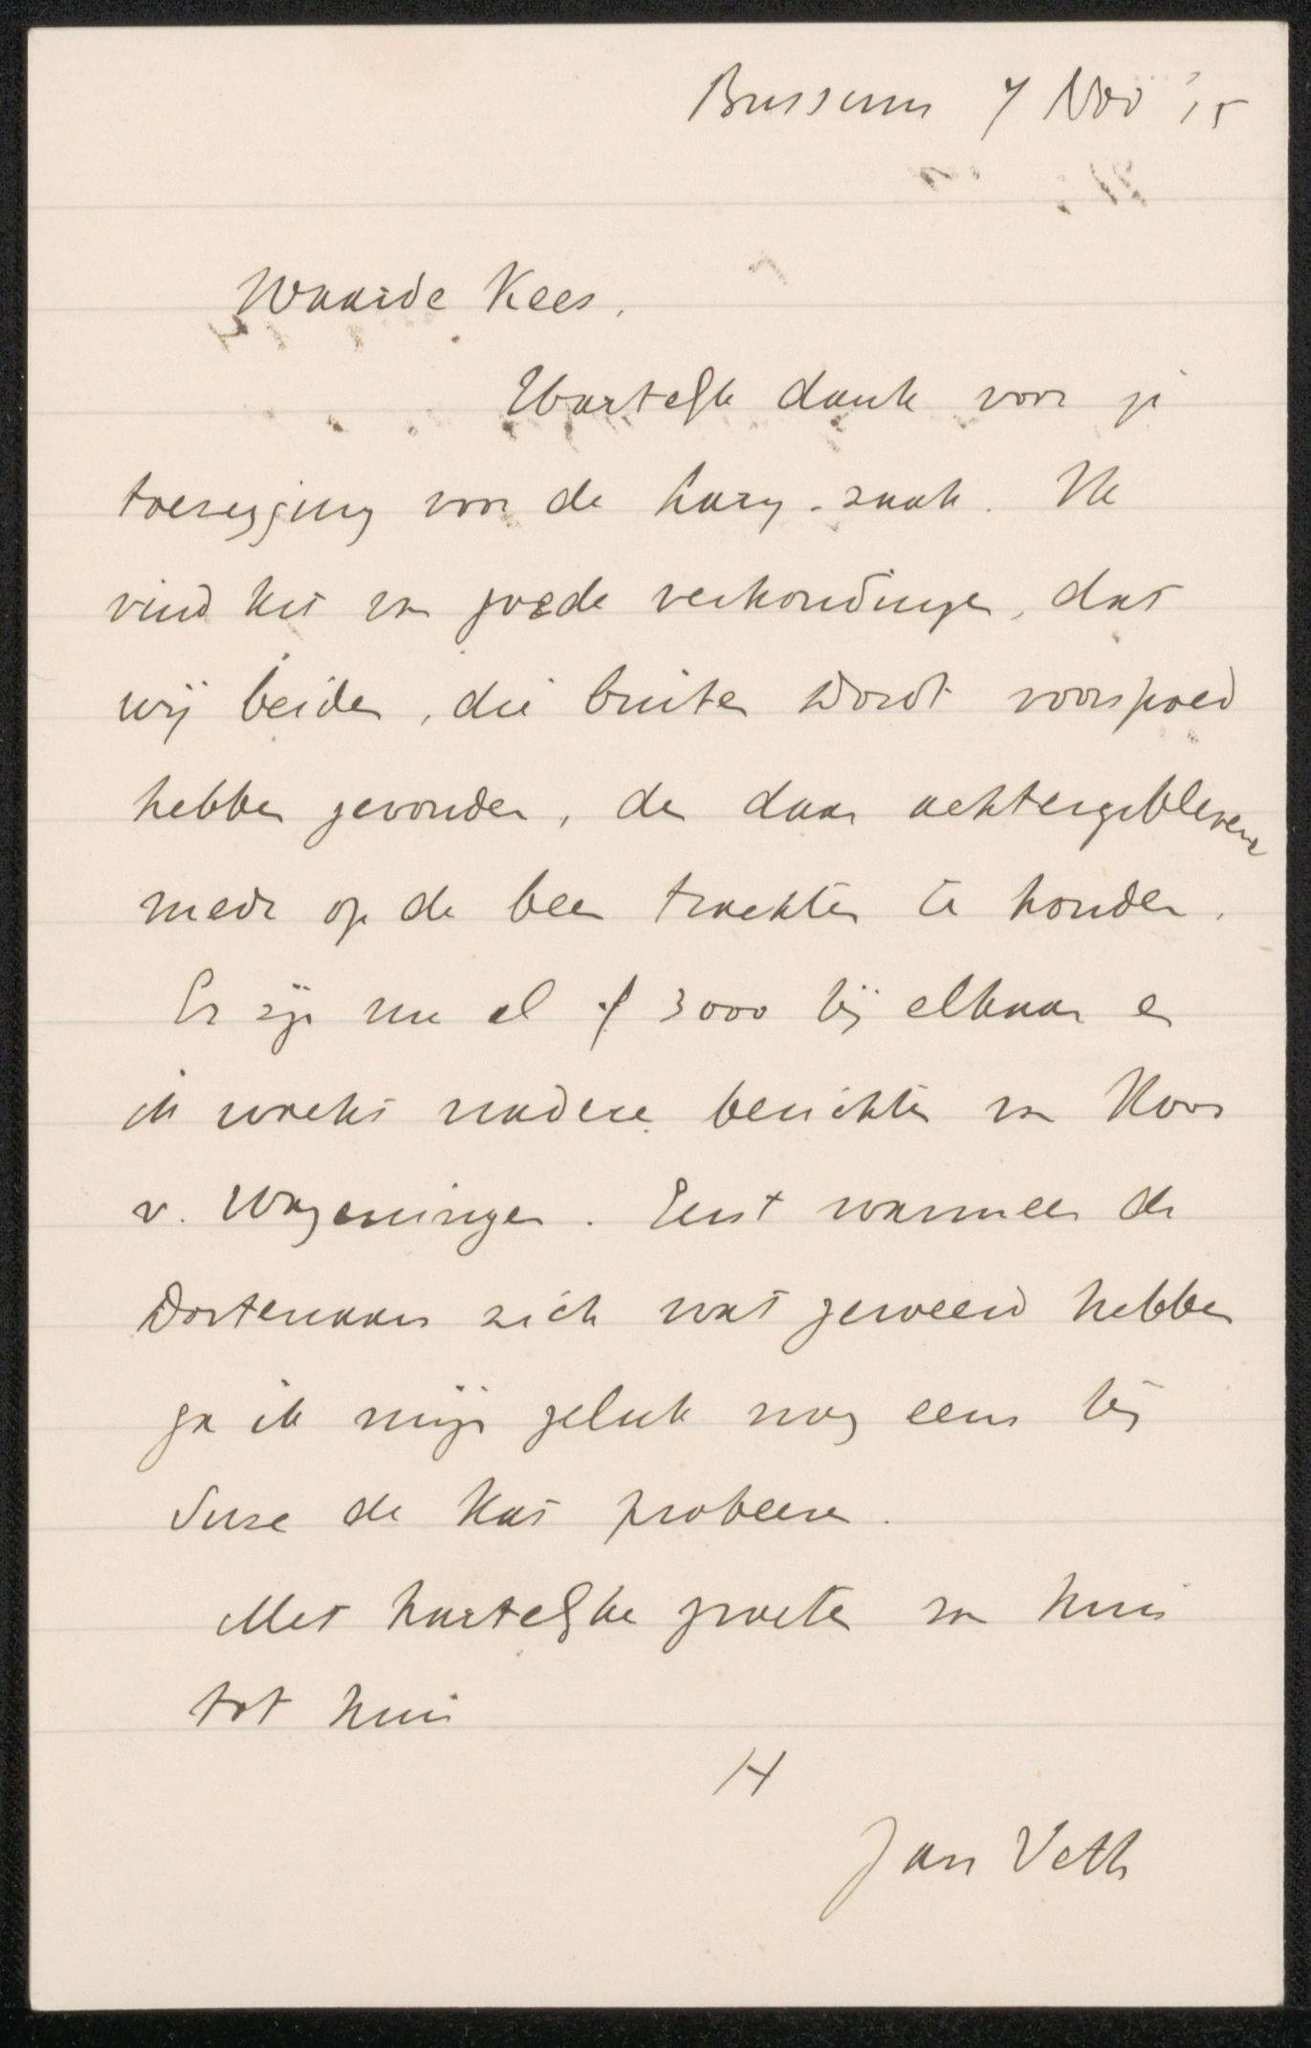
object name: letter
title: Brief aan Cornelis Gerardus 't Hooft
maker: jan veth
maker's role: designer, draughtsman, painter, print maker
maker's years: 1864-1925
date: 1915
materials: ink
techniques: pen, writing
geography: bussum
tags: dordrecht, amsterdam, painter, draughtsman, cornelis gerardus 't hooft, money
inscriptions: collector's mark: ‘RPK’